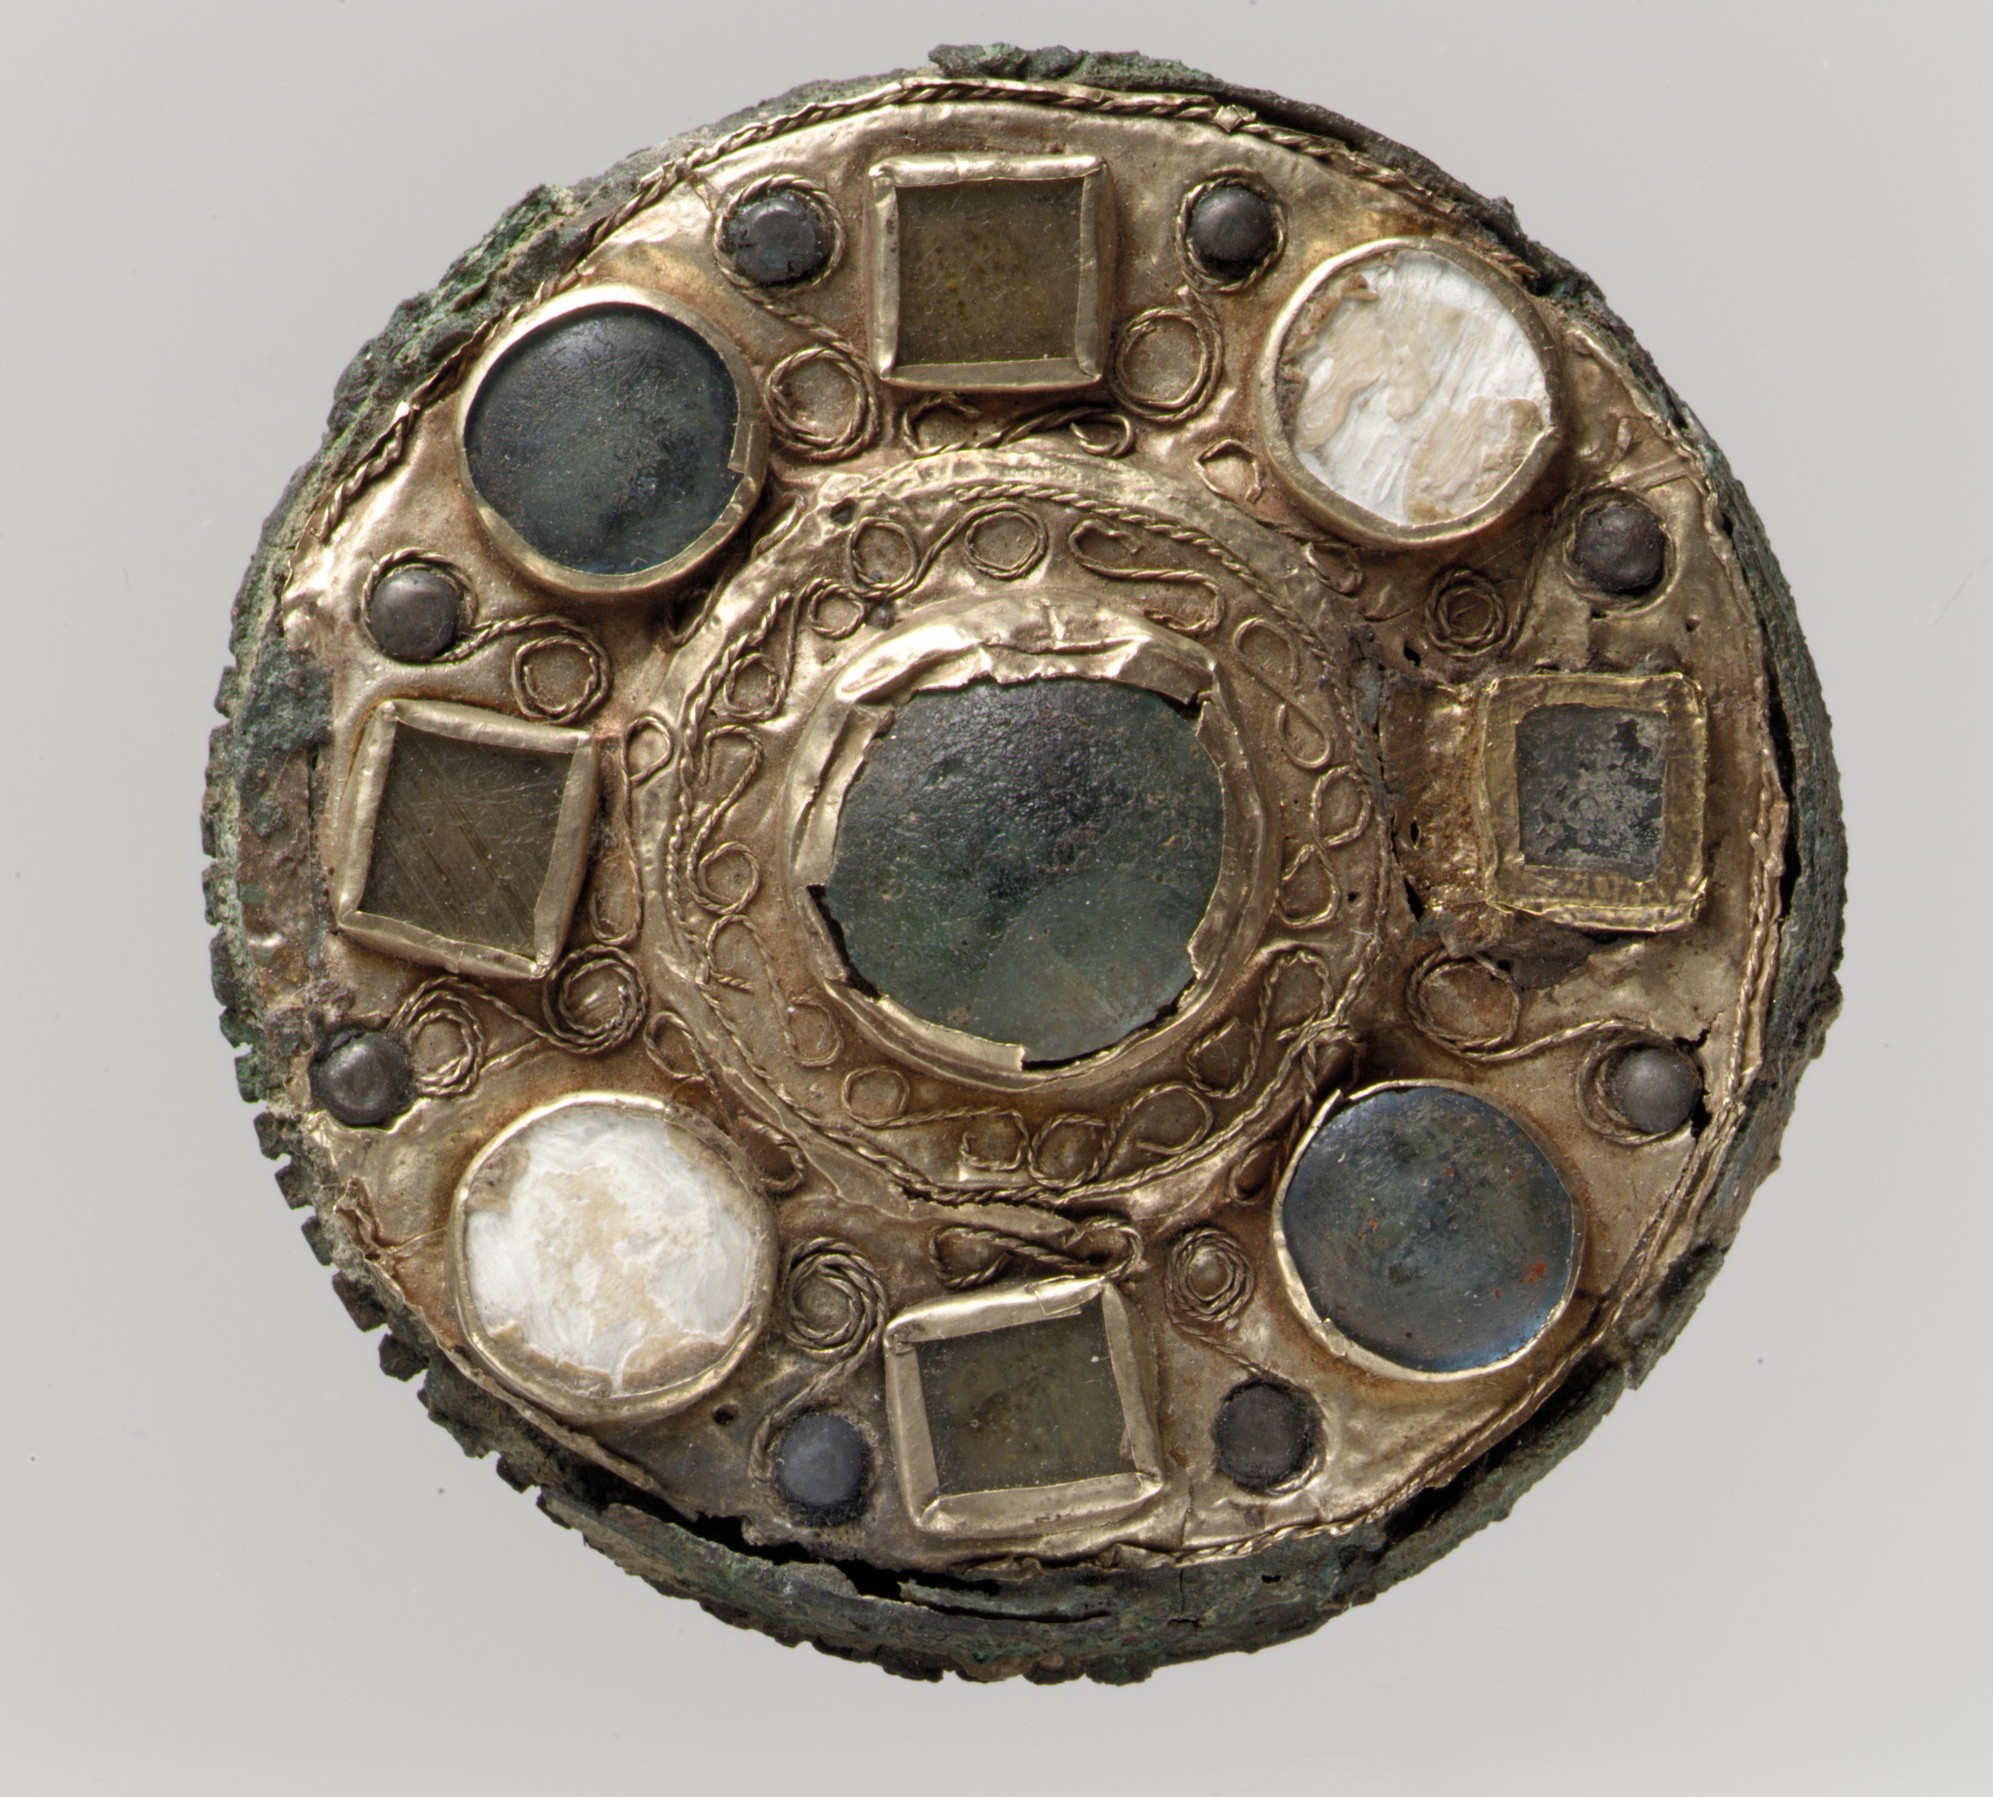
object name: brooch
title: Disk Brooch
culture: frankish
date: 601-700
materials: copper alloy, glass, gold, mother of pearl, silver